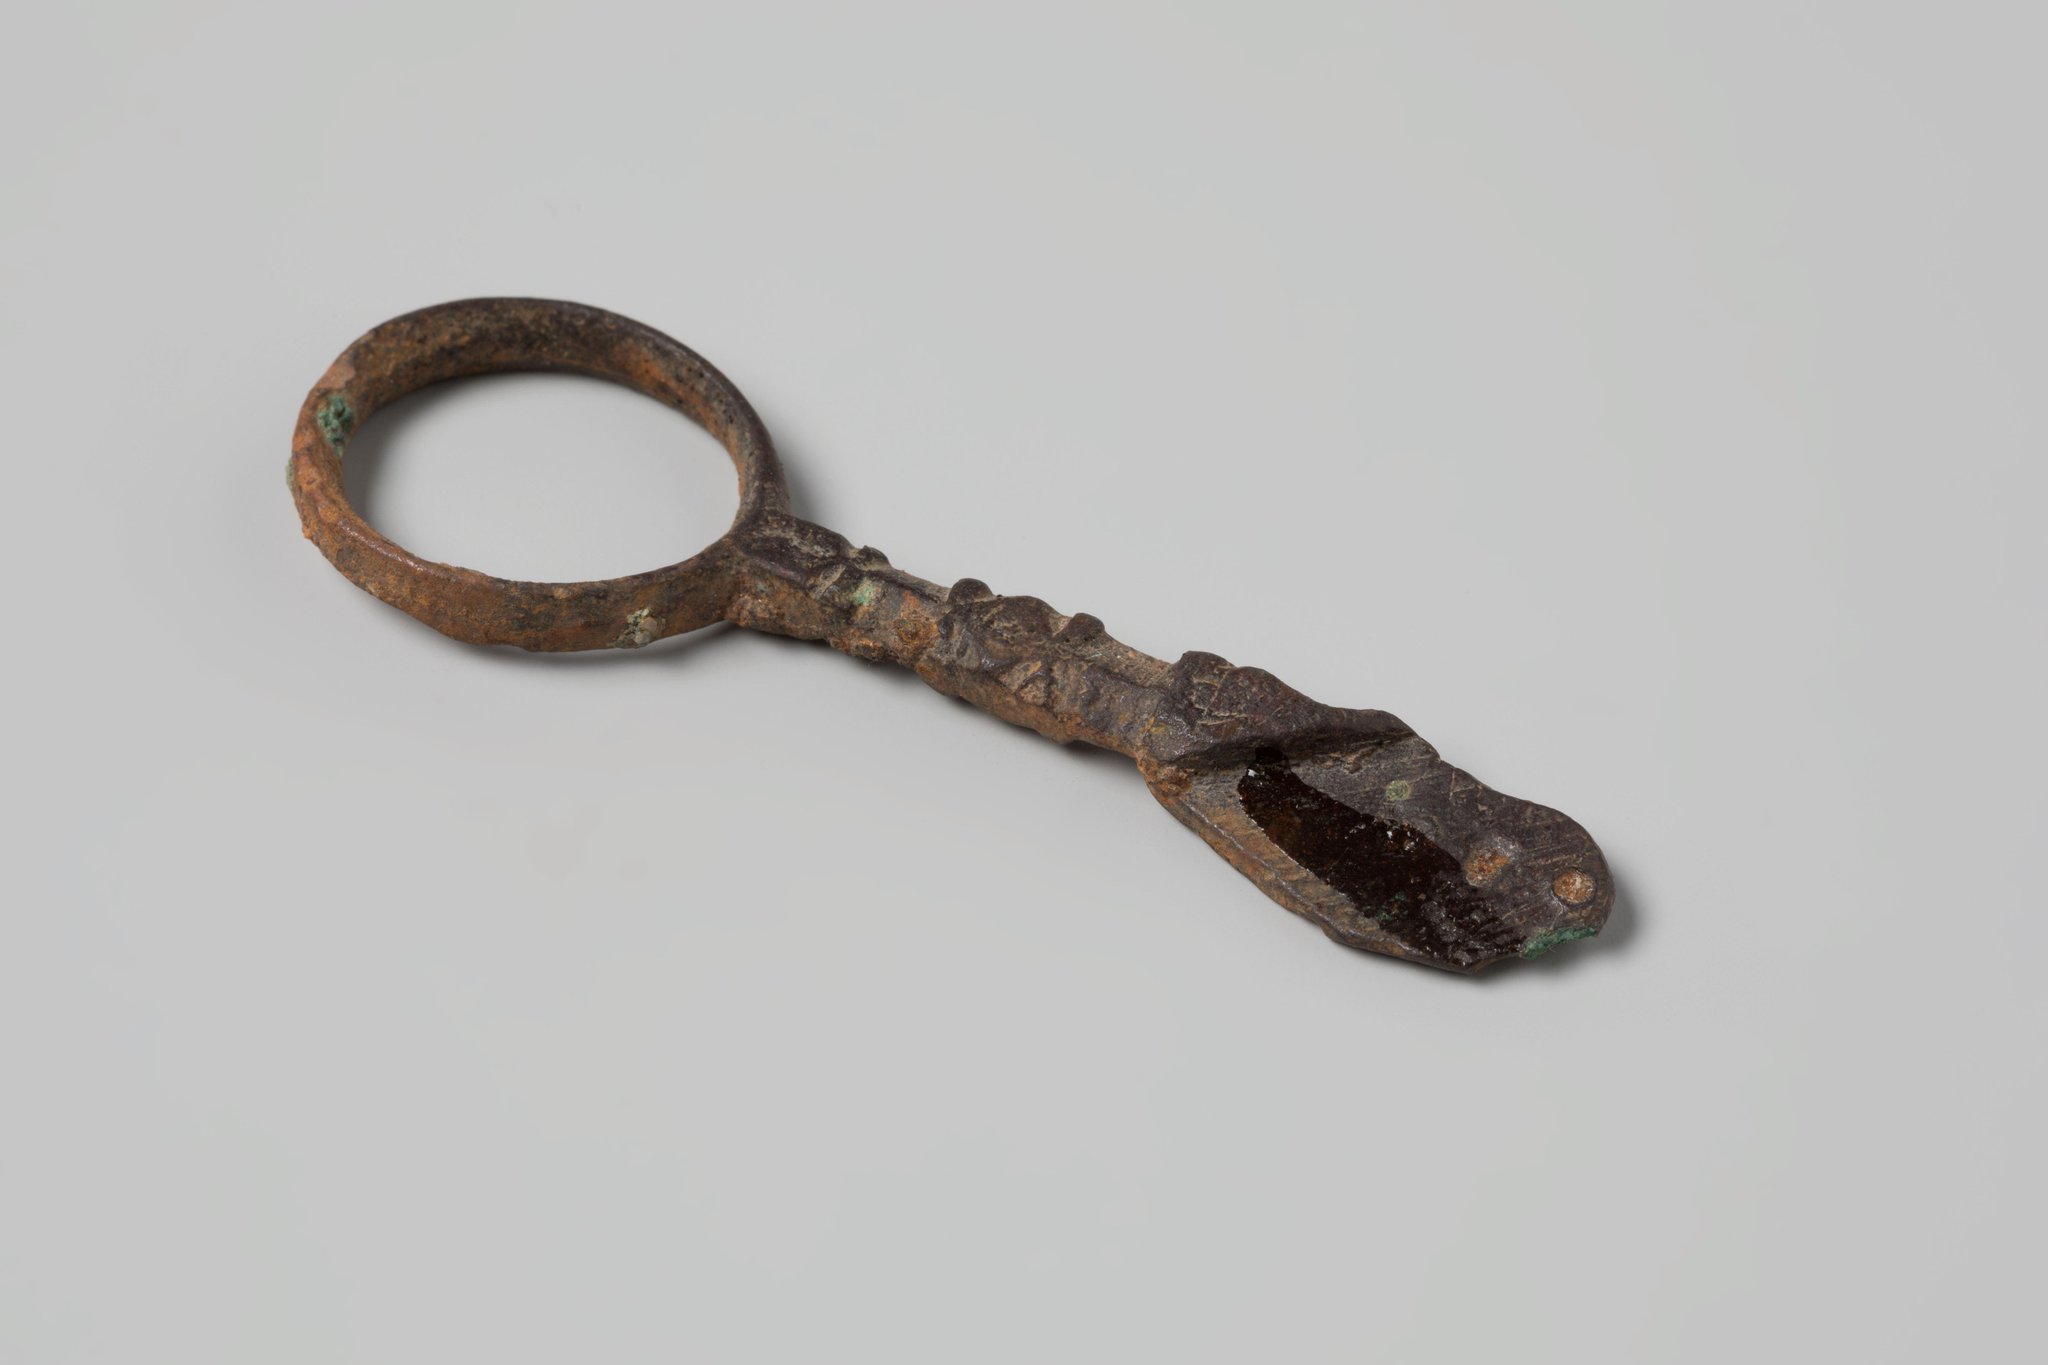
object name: pin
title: Speld uit het wrak van de Oost-Indiëvaarder Hollandia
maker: Anonymous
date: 1700-1743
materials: copper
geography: netherlands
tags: verenigde oostindische compagnie, hollandia (schip), annet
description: Tools and instruments, sewing and sailmaking, pin; fragm, handle, id. NG 1980-27H3265.